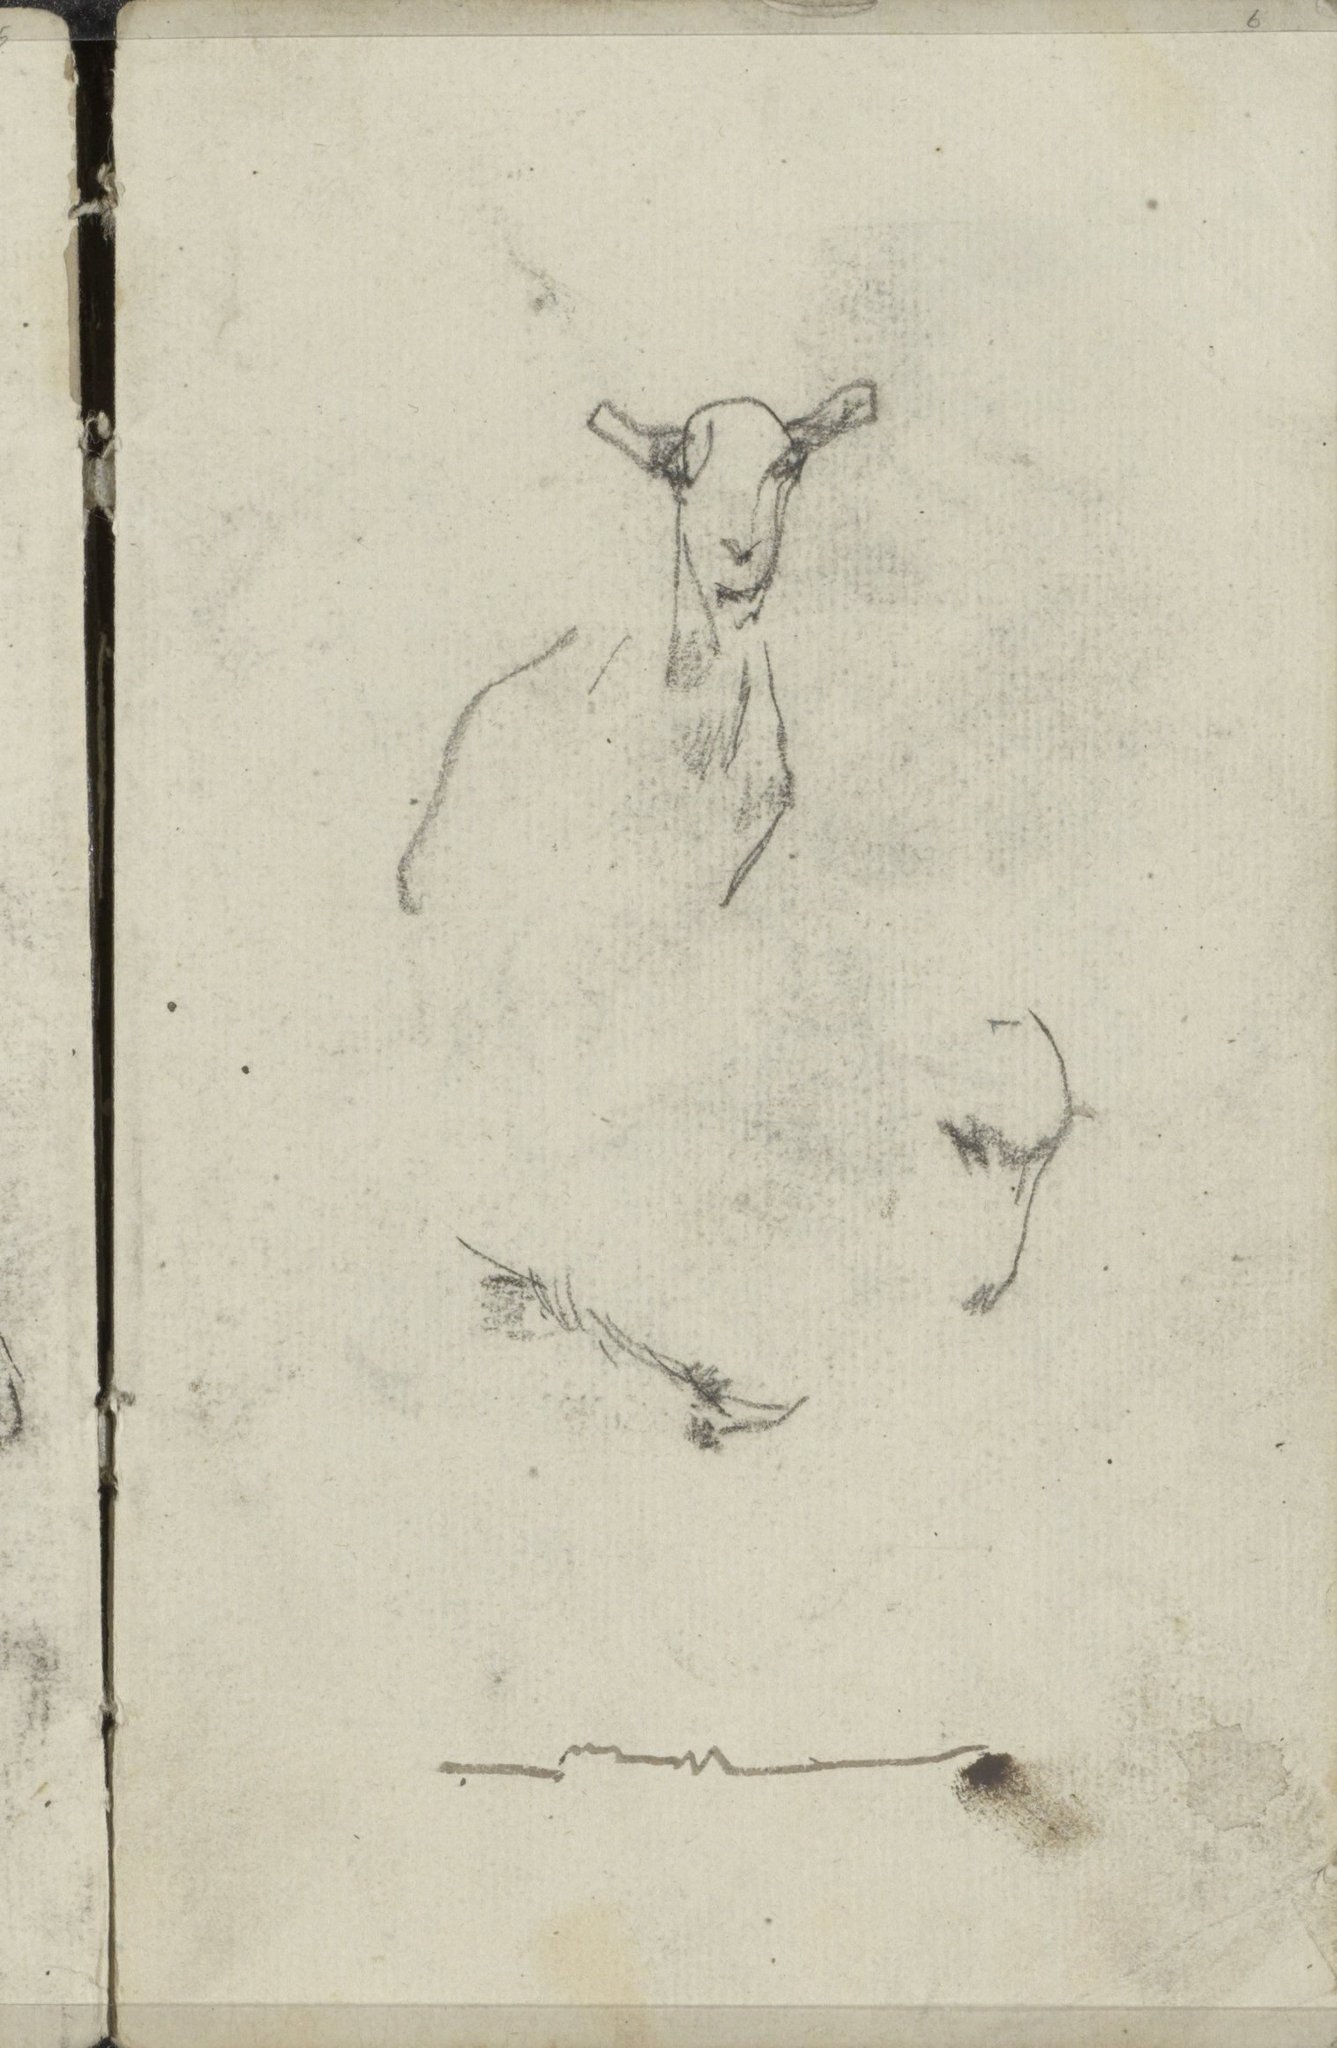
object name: sketchbook leaf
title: Geit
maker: george hendrik breitner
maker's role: draughtsman, painter, print maker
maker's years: 1857-1923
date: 1883-1885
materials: chalk, paper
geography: the hague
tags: goat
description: Pagina 6 uit een schetsboek met 17 bladen.